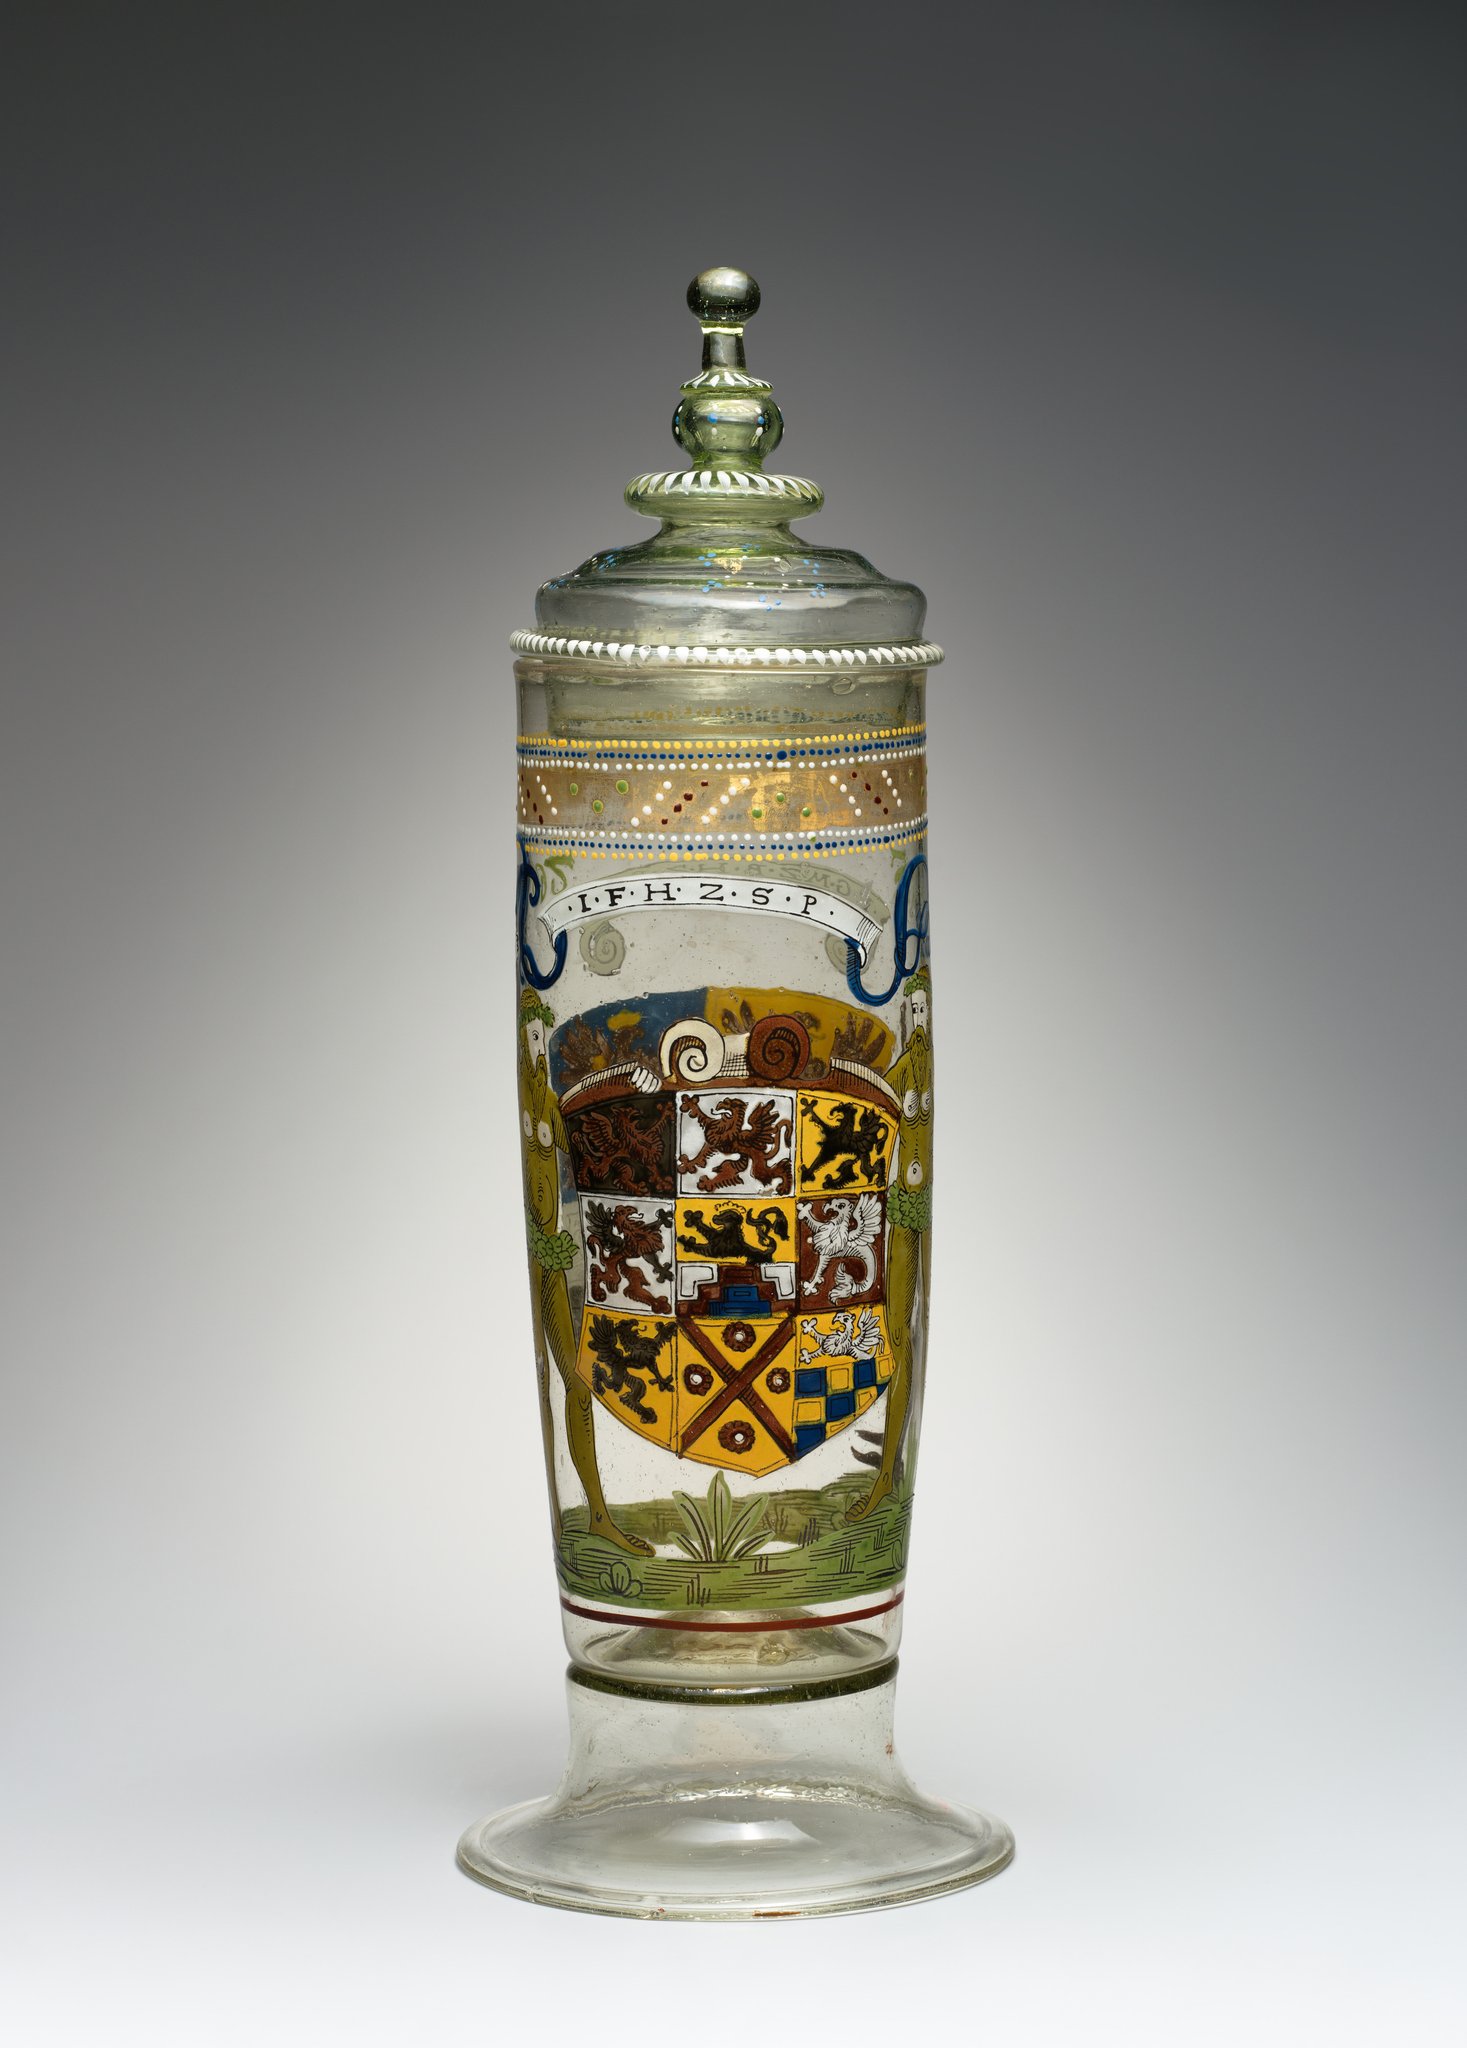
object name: beaker with cover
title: Beaker with cover (Deckelhumpen)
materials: glass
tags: men,coat of arms